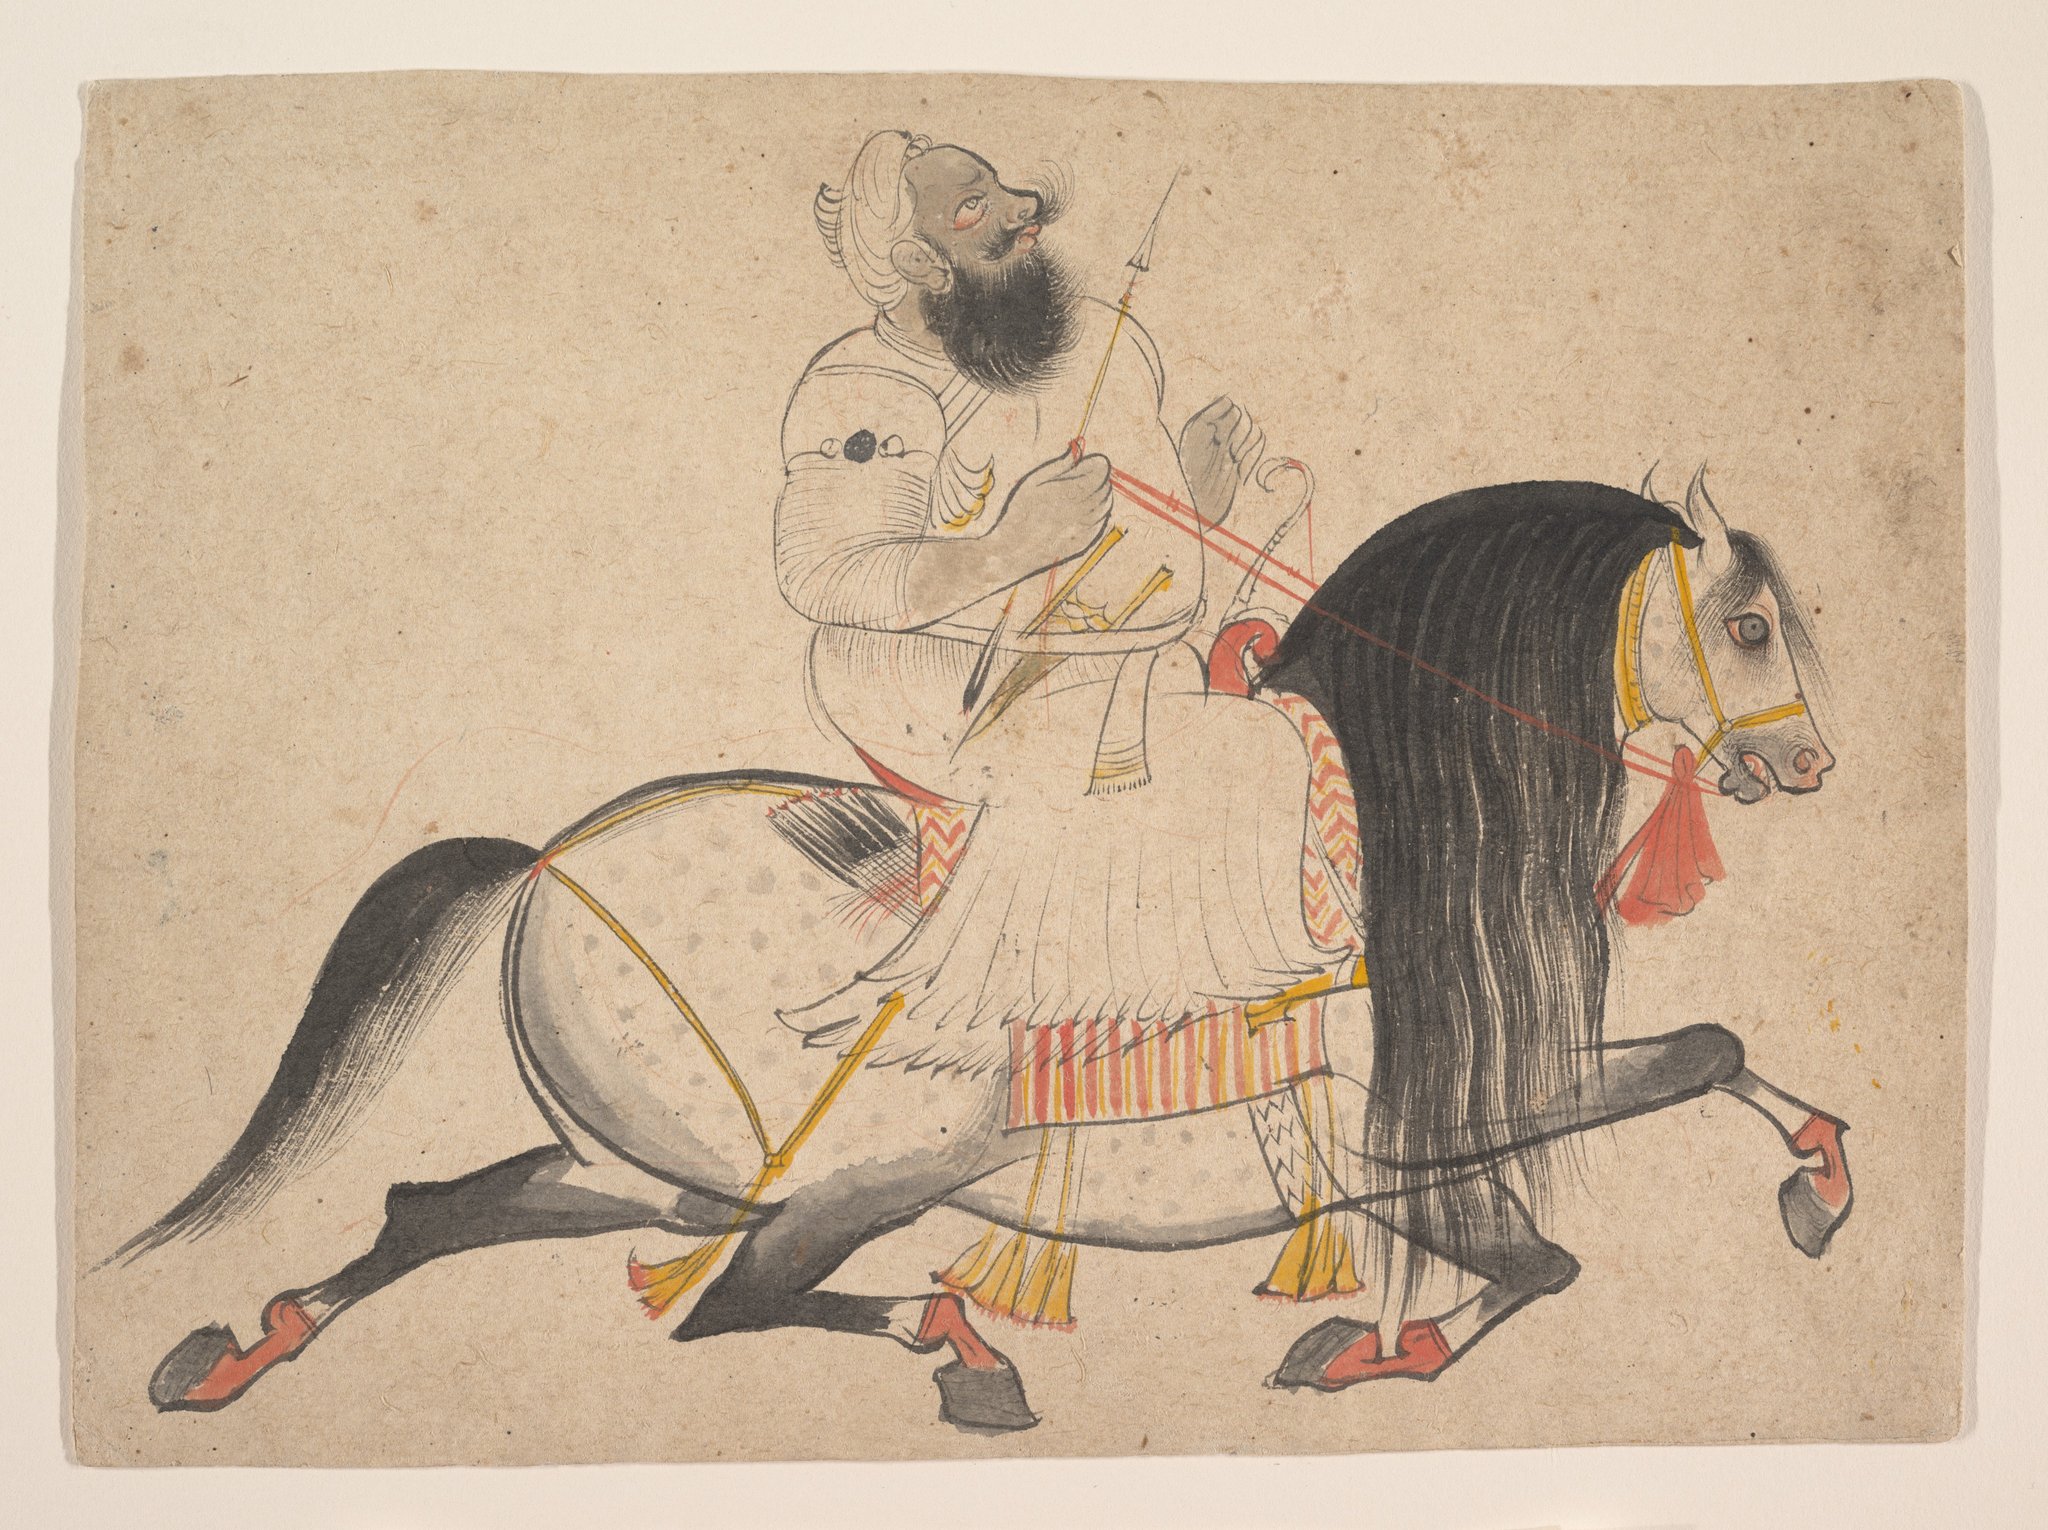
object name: painting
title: Equestrian Portrait of a Noble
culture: indian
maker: bakhta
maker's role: artist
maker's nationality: indian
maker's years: 1775-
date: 1775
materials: ink, paper, watercolor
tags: men,horses